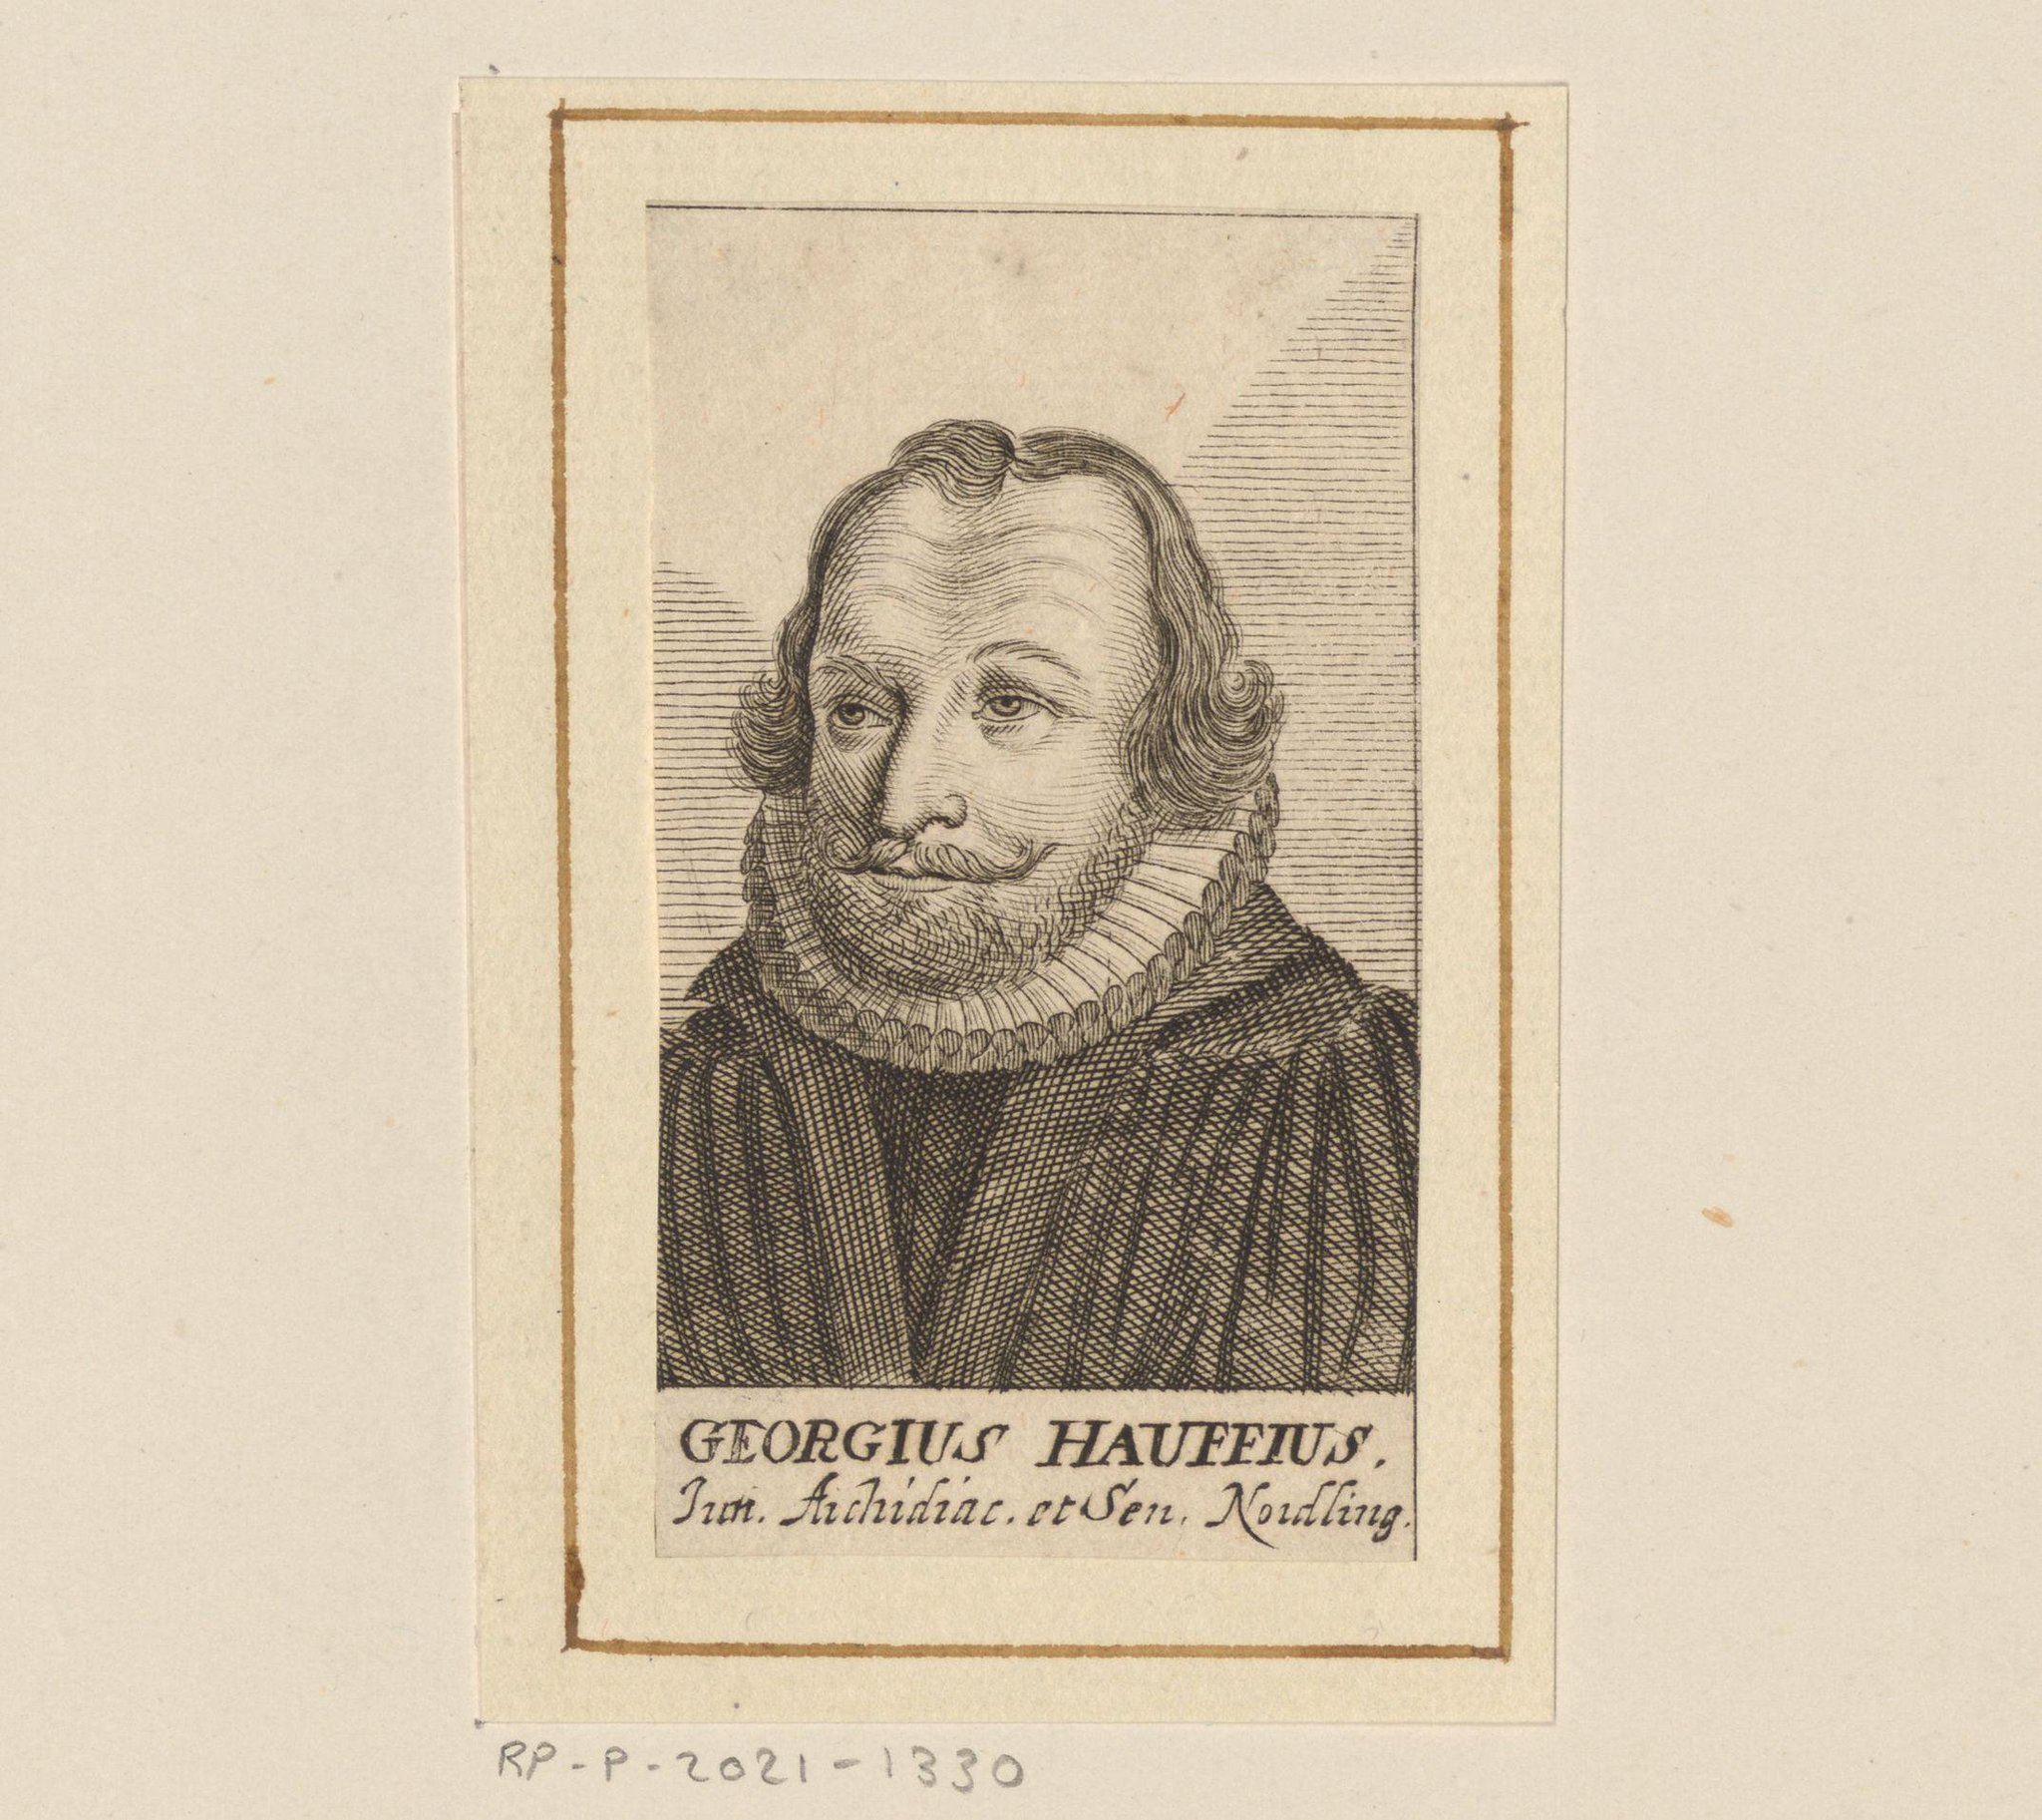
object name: print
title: Portret van Georg Hauff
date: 1688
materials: paper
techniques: engraving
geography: nuremberg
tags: theologian, historical persons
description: Prent uit: Freher, Paul. Theatrum virorum eruditione clarorum. Neurenberg: Johann Hoffmann, 1688.